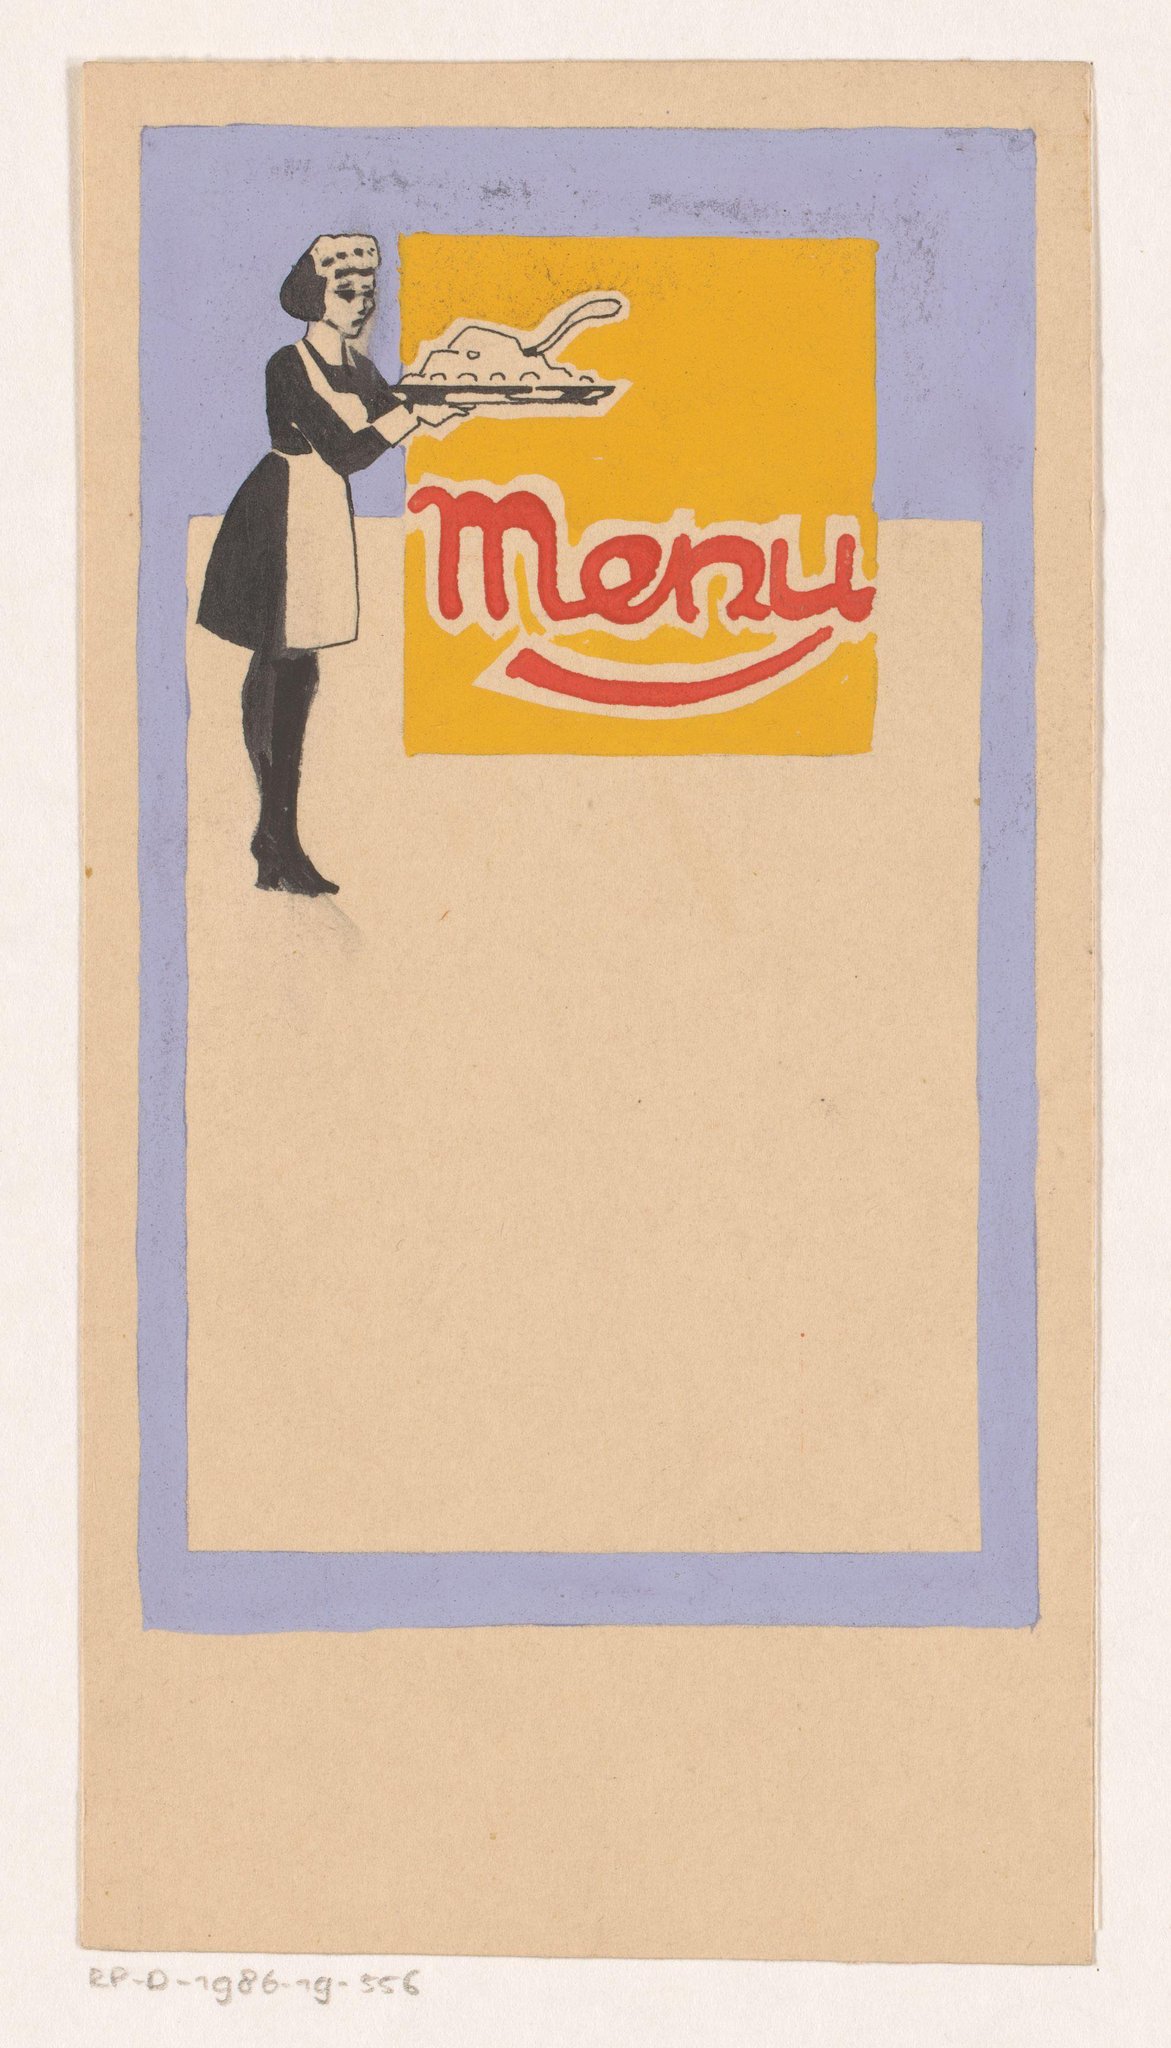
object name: drawing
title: Ontwerp voor een menukaart met een serveerster met schaal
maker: reinier willem petrus de vries (1874-1953)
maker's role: draughtsman, print maker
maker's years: 1874-1953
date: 1884-1952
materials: ink, paint, paper, pencil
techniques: brush, pen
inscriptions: collector's mark: ‘R:MVS.’